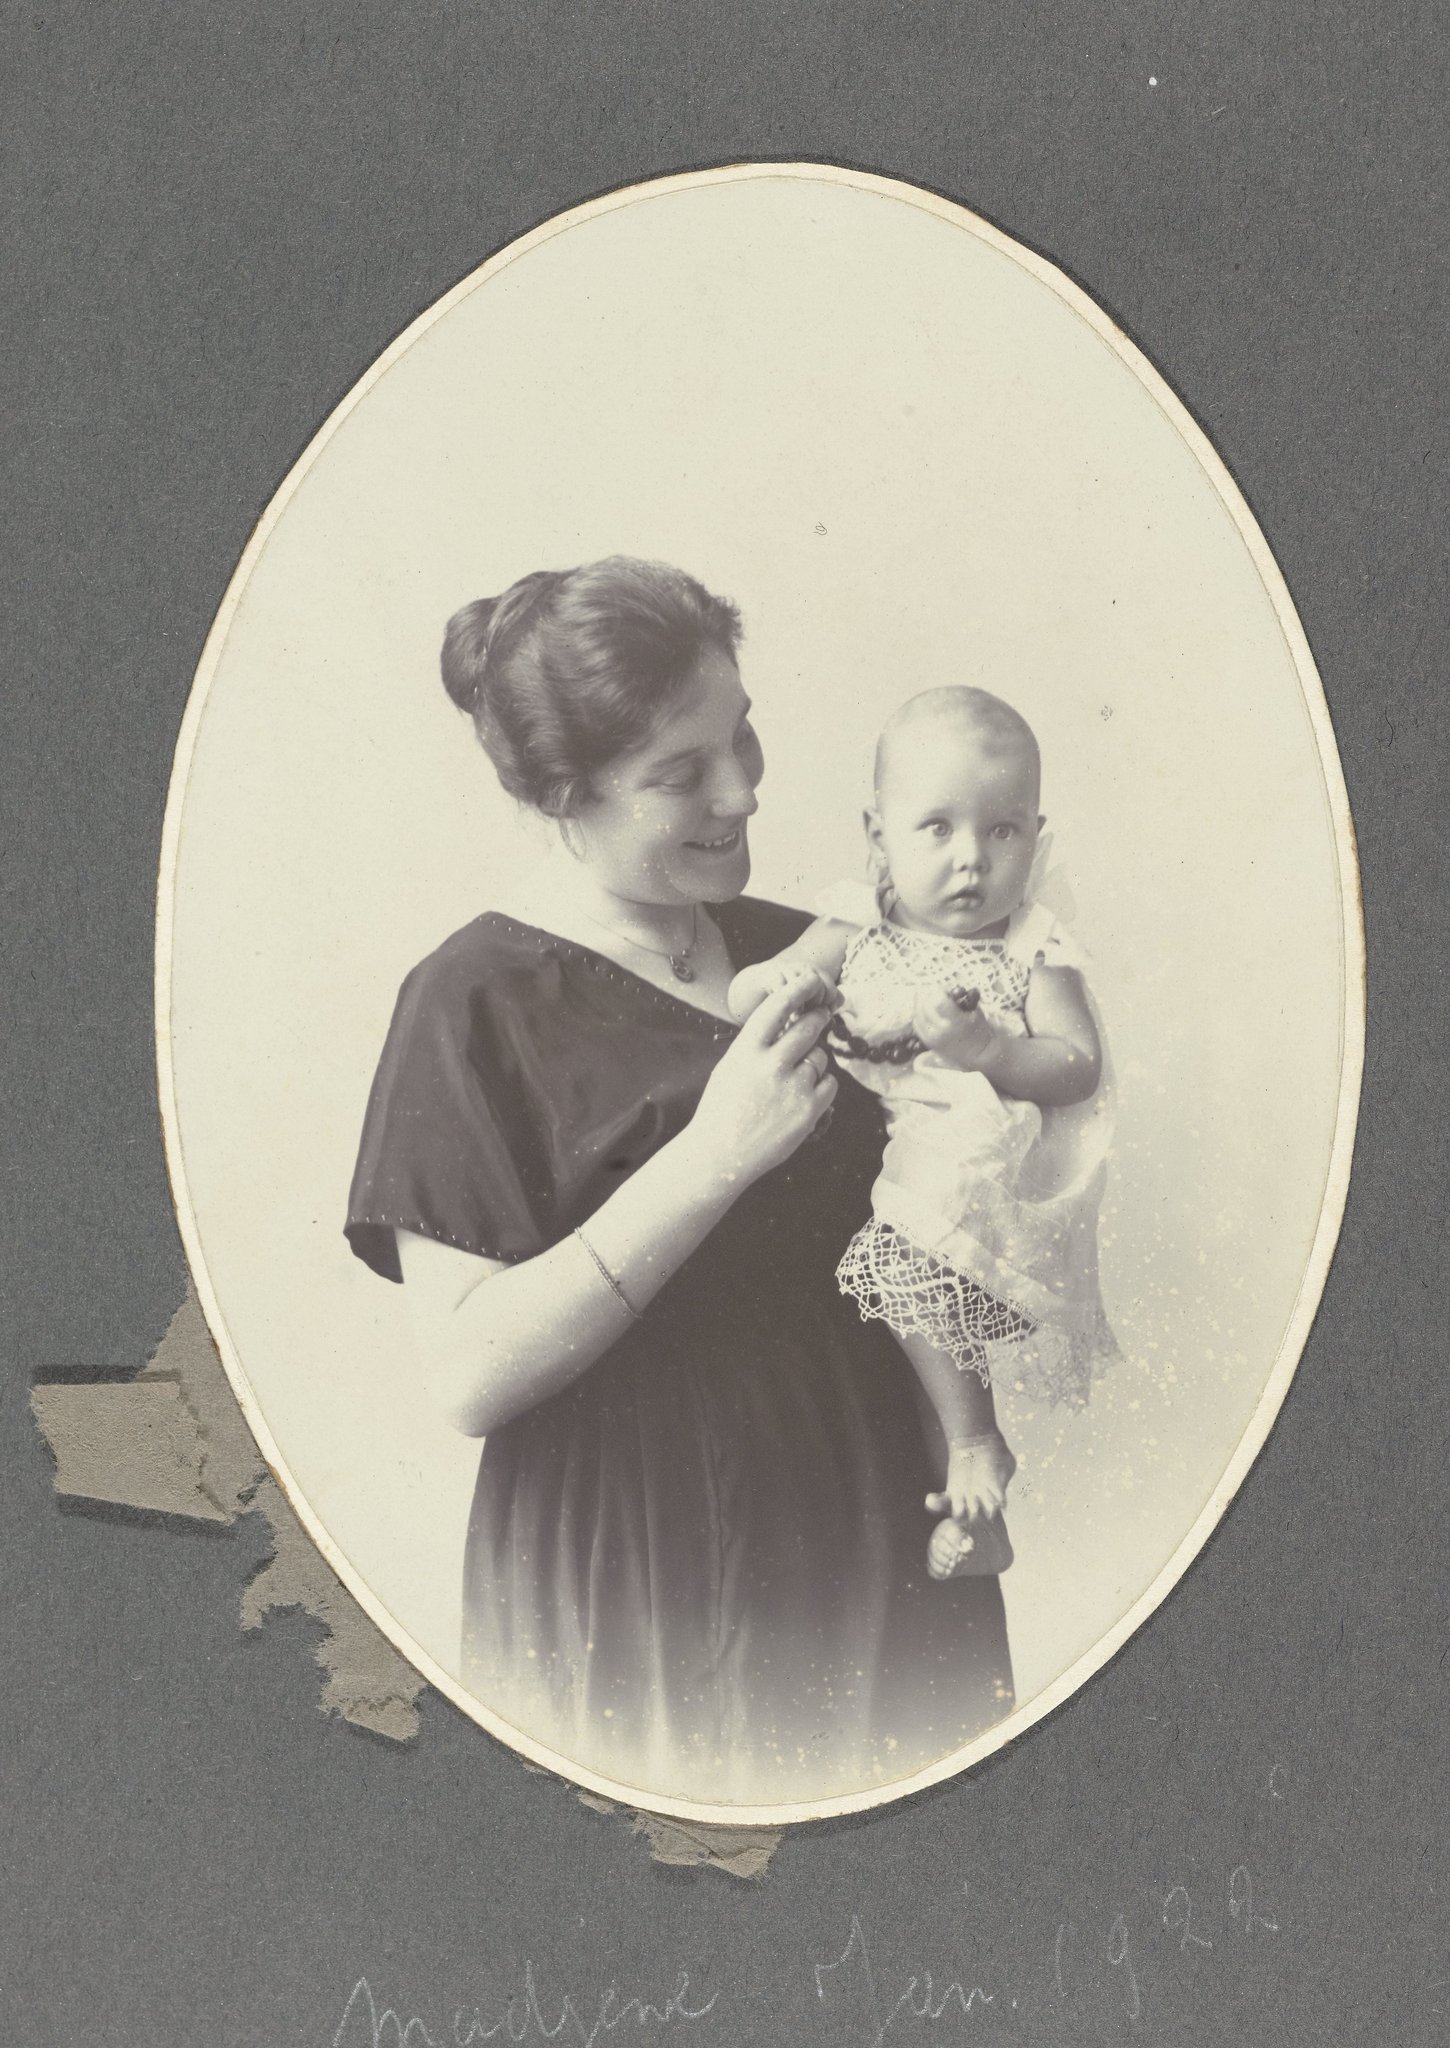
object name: photograph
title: Portret van een Tine Kleiterp-Vermeulen met haar zoon Klaas op de arm in Madjene op Celebes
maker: klaas kleiterp (i)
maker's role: arts, officier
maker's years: 1892-1943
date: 1901-1922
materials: paper, photographic support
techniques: daylight paper print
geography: madjene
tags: mother and baby or young child, dutch east indies, the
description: Onderdeel van Fotoalbum van de familie Kleiterp-Vermeulen met opnames van de kinderen Klaas en Tiny in Nederlands-Indië.